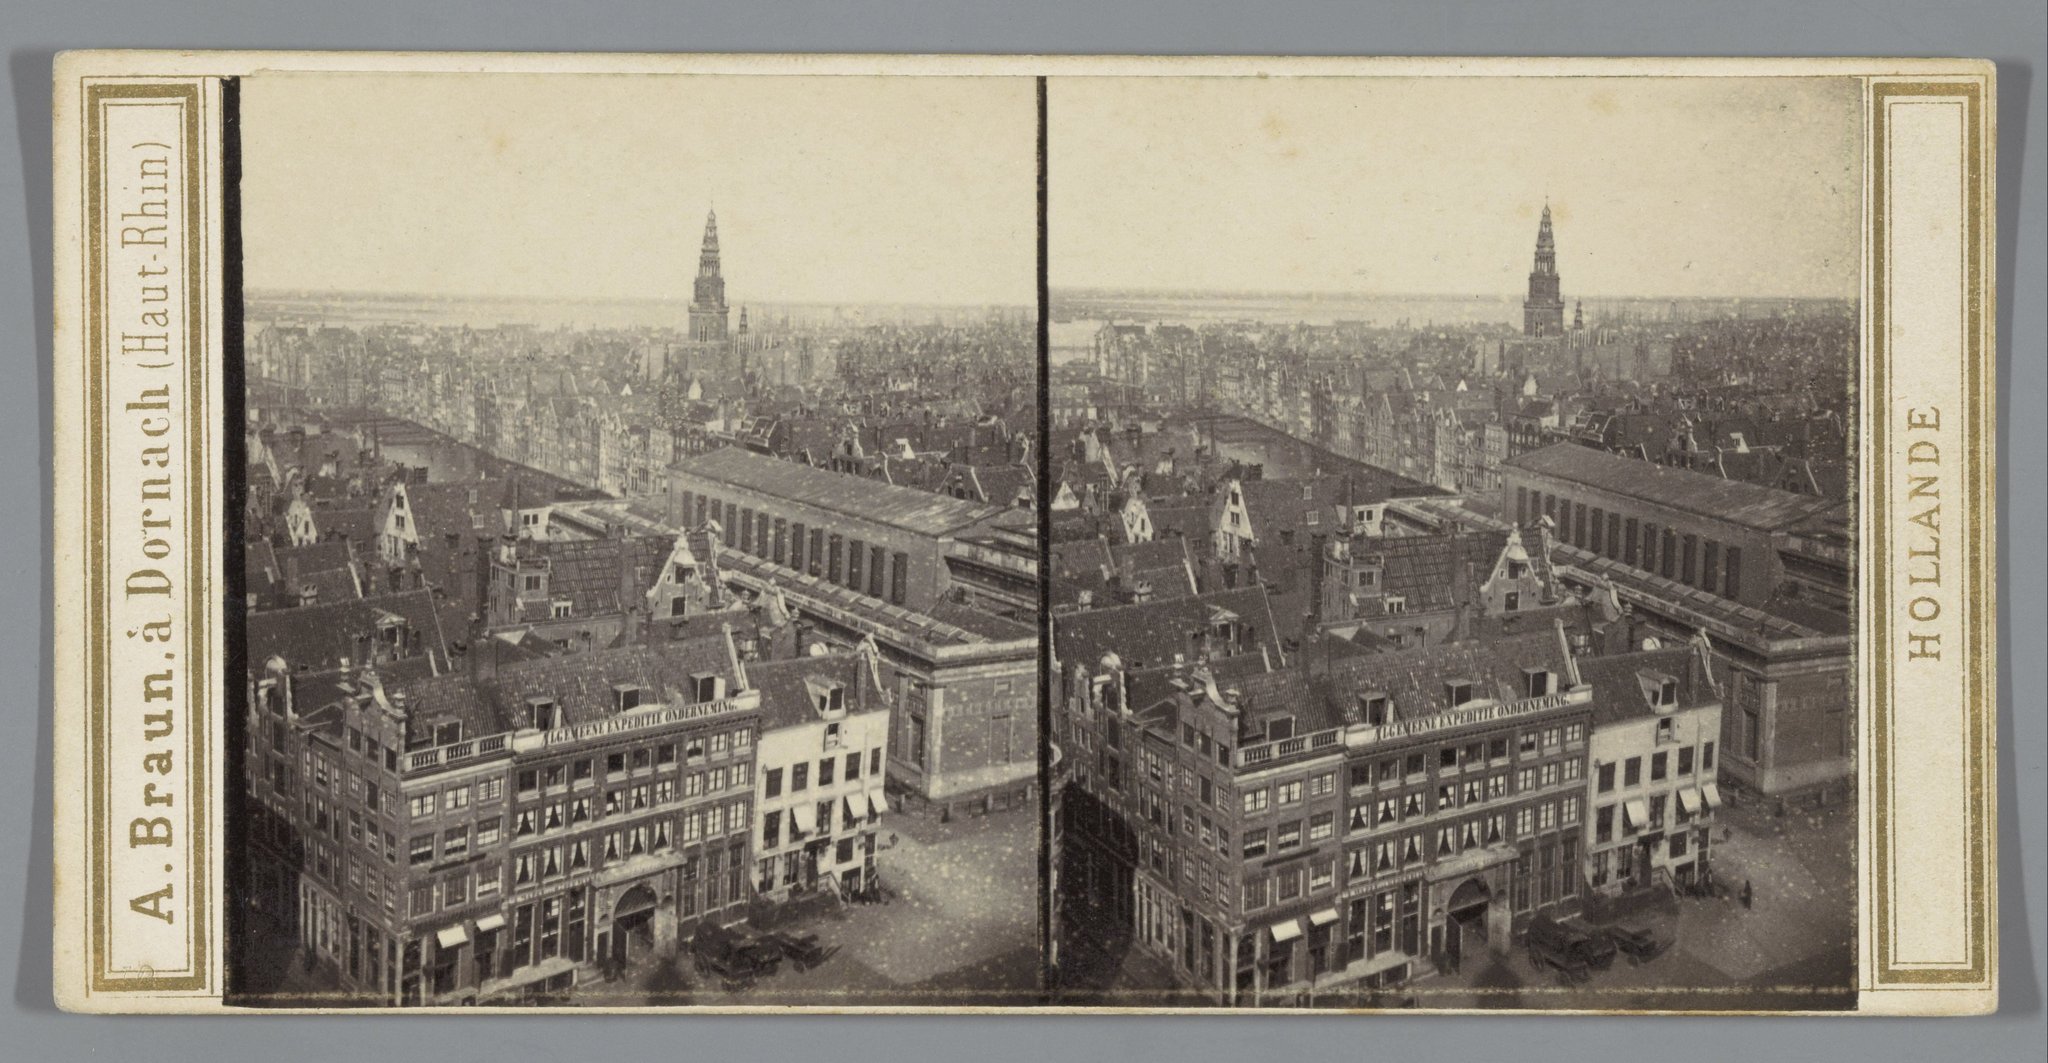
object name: stereograph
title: Gezicht op Amsterdam-Noordoost. Uitzicht vanaf het Paleis op de Dam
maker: gaston braun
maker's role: fotograaf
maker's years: 1845-1928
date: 1864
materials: cardboard, paper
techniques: albumen print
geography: amsterdam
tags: city-view in general; 'veduta', amsterdam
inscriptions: number: ‘No 3936.’, name: ‘J. C. MEERBURG,’, stamp: ‘S. A. MEERBURG/ LEIJDEN’